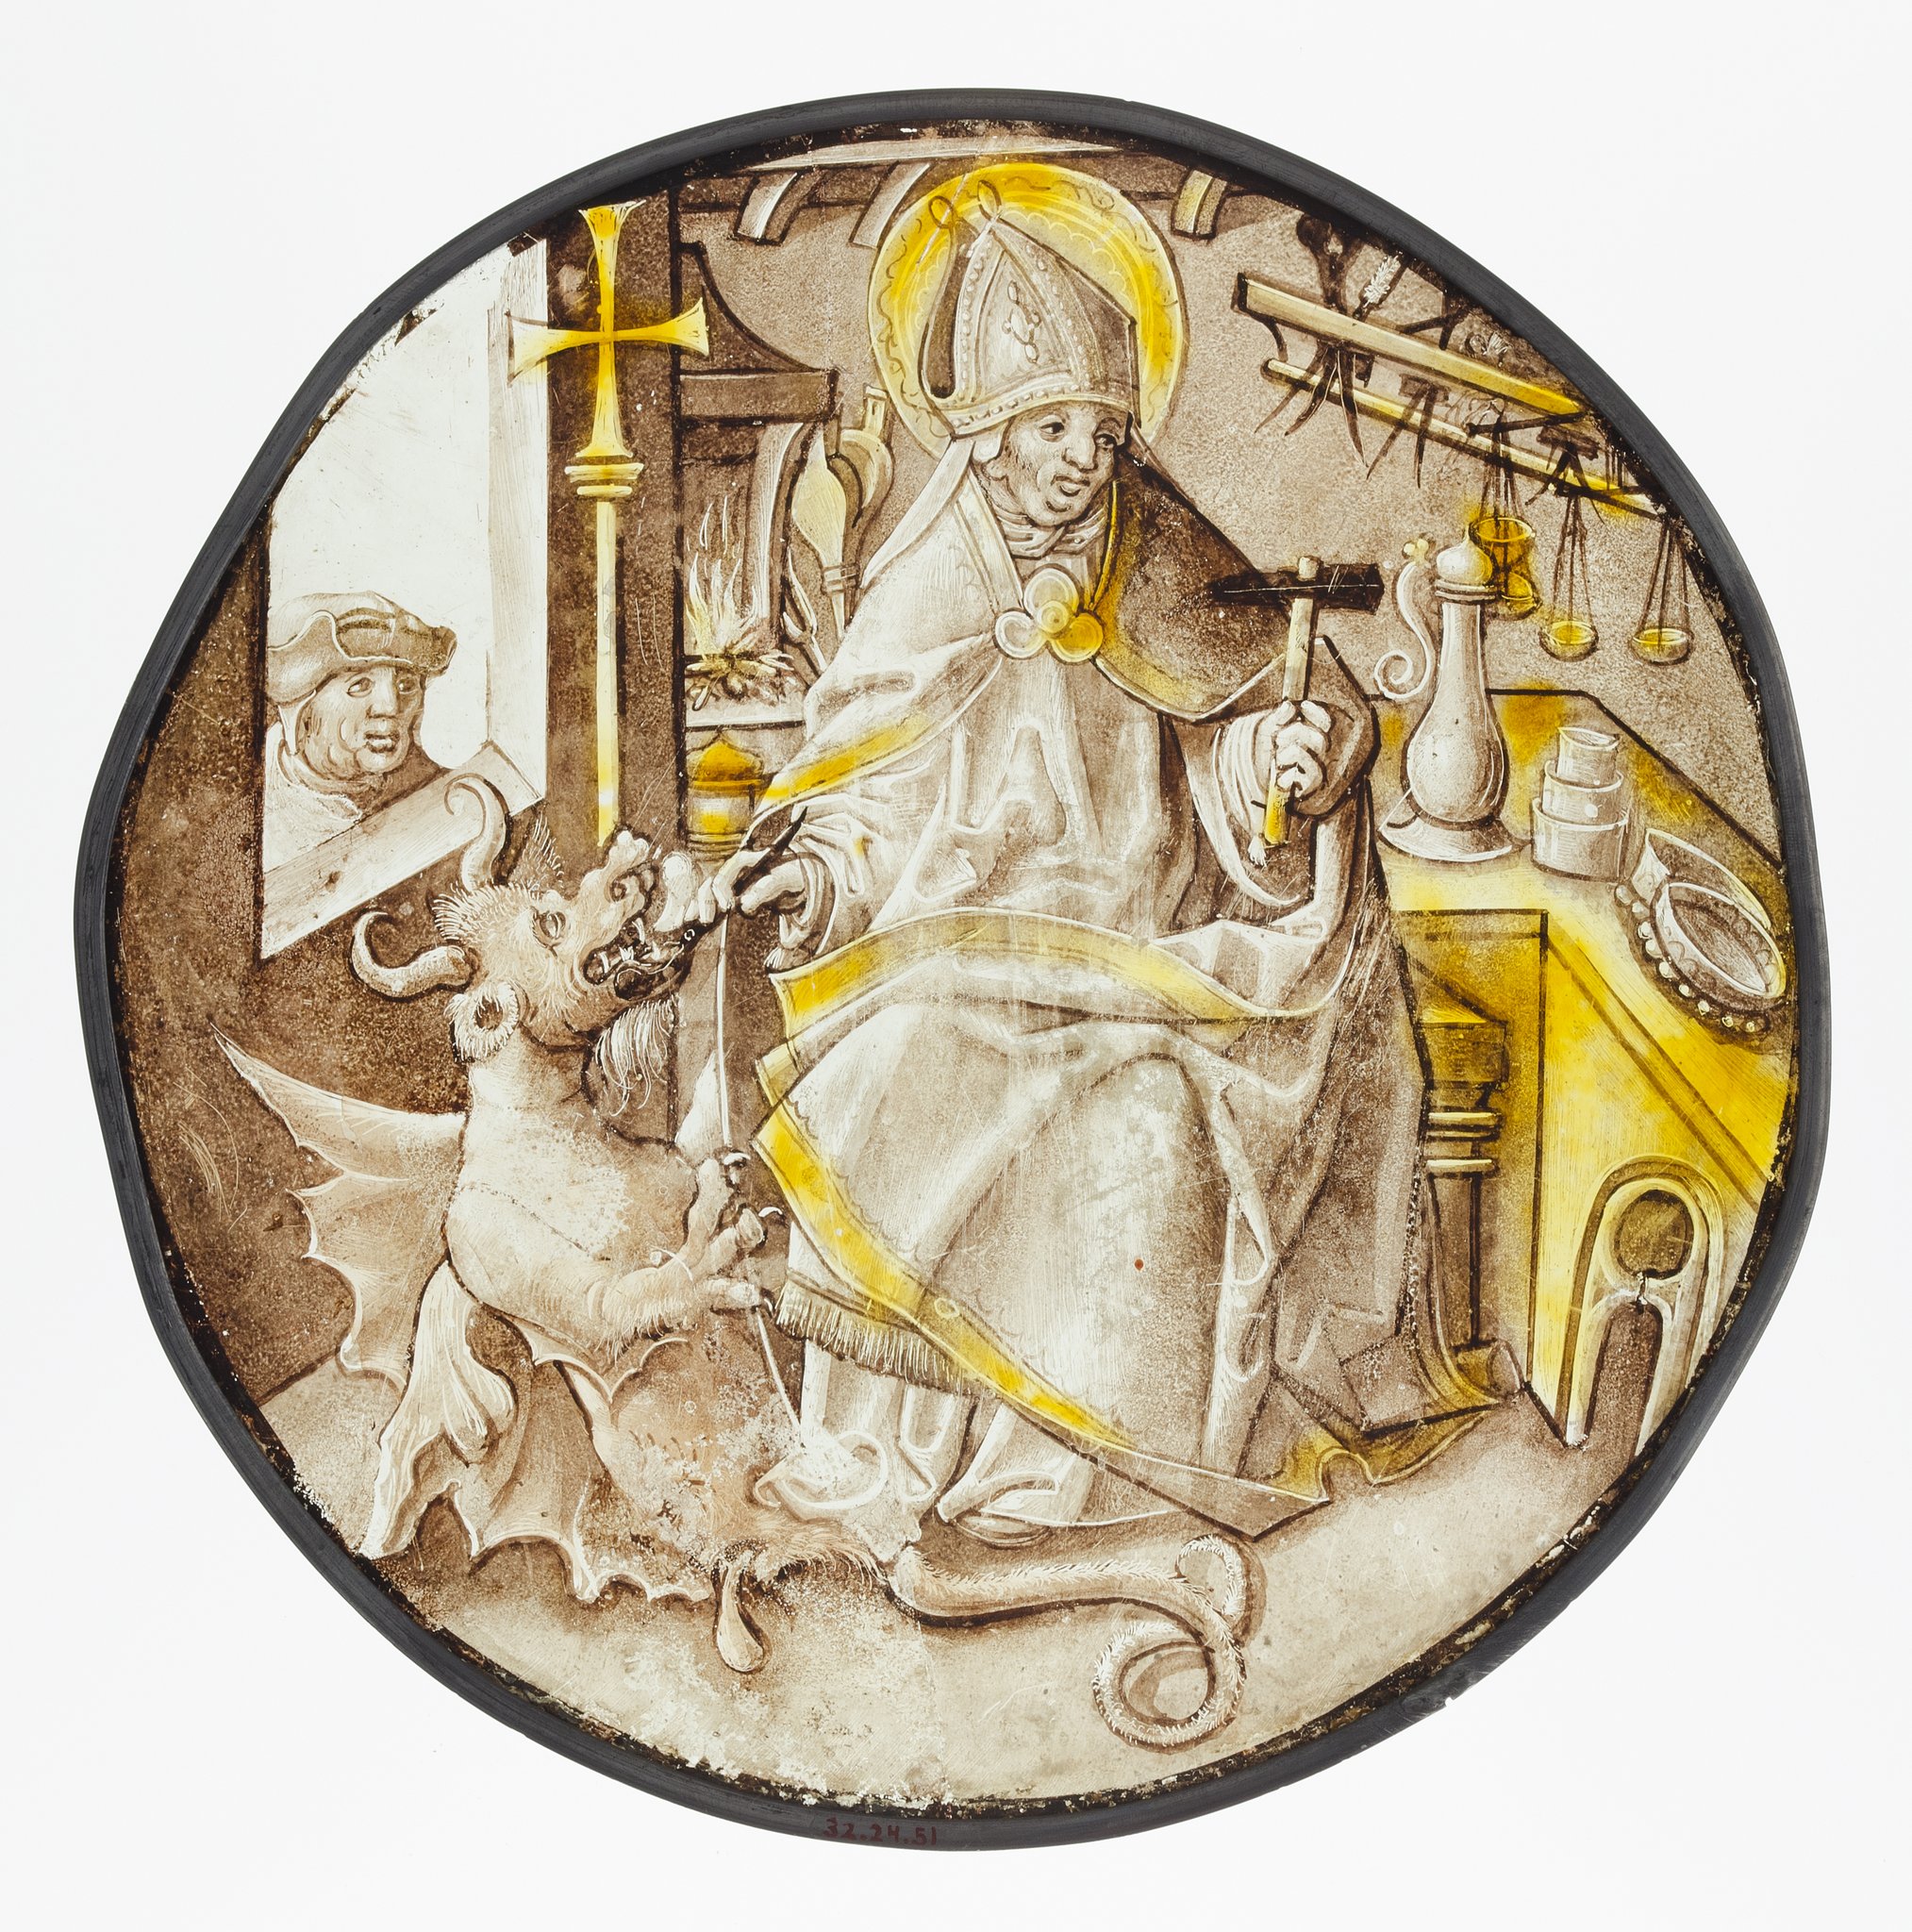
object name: roundel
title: Roundel with Saint Dunstan of Canterbury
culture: south netherlandish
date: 1510-1520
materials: glass, paint, pigment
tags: interiors,men,devil,saints